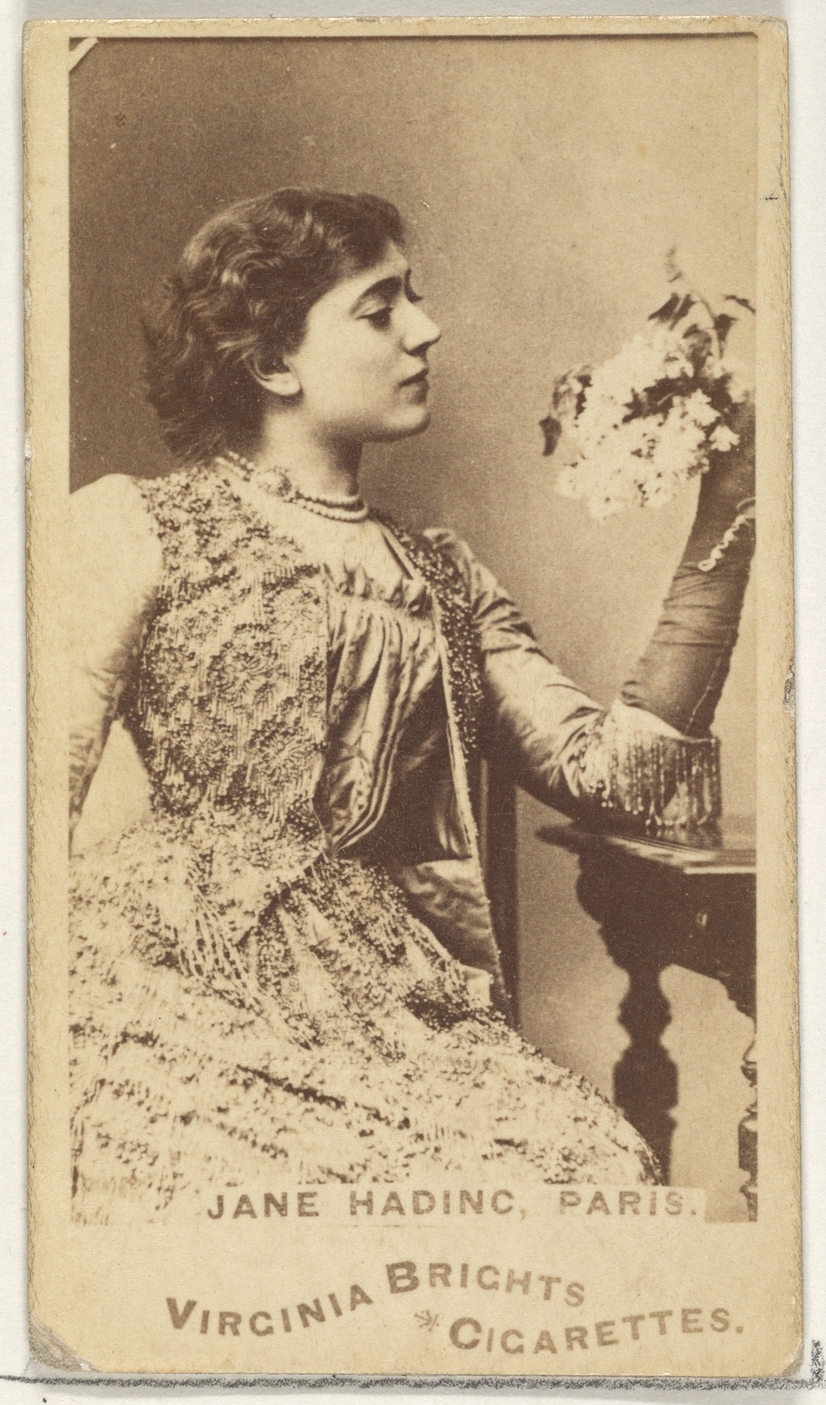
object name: photograph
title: Jane Hading, Paris, from the Actors and Actresses series (N45, Type 1) for Virginia Brights Cigarettes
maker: allen & ginter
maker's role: publisher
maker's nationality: american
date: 1888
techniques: albumen silver print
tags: portraits,profiles,women,actresses